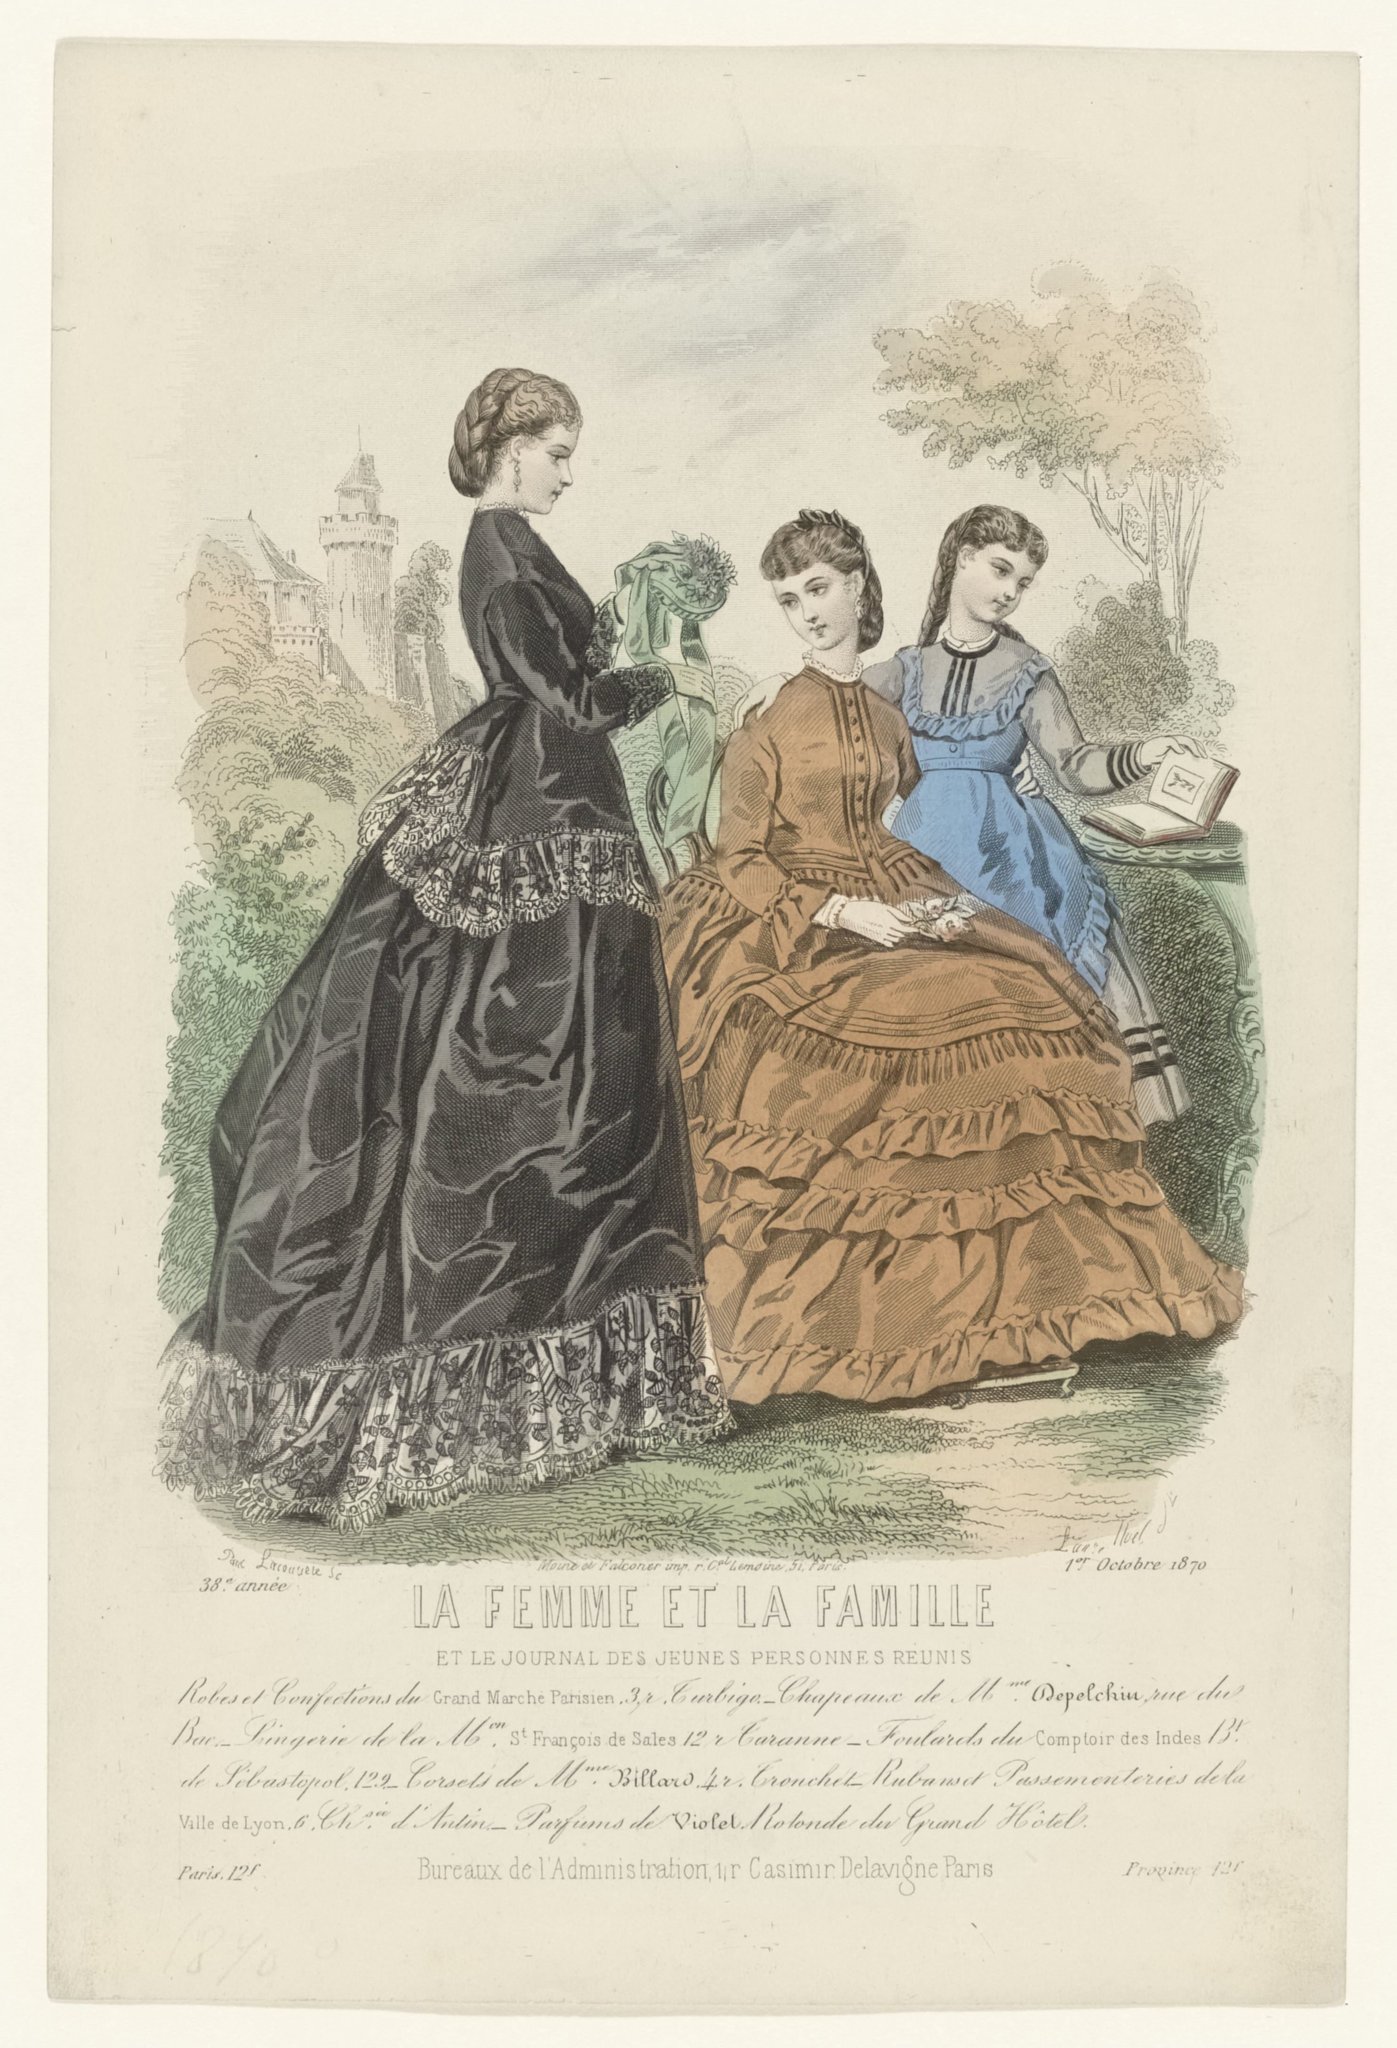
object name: fashion print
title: La femme et la famille et le journal des jeunes personnes reunis, 1 octobre 1870, 38e année: Robes et Confections (...)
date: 1870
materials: paper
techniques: engraving, hand coloring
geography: paris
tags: cut flowers; nosegay, bunch of flowers, fashion plates, head-gear: hat (+ women's clothes), dress, gown (+ women's clothes), book - mm - book open, dress, gown (+ girls' clothes)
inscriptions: caption: ‘Robes et Confections du Grand Marche Parisin, 3, r. Turbigo. _ Chapeaux de Mme Depelchin, rue du Bac_ Lingerie de la M.on St François de Sales 12 r Taranne _ Foulards du Comptoir des Indes B.t de Sébastopol, 129_ Corsets de Mme Billard 4. r. Cronchet_ Rubans et Passementeries de la Ville de Lyon. 6. Ch.sée_ Parfums de Violet. Rotonde du Grand Hôtel.’, address: ‘Paris. 12f / Bureaux de l'Administration, 1, r Casimir Delavigne Paris / province 12 f’, title: ‘LA FEMME ET LA FAMILLE / ET LE JOURNAL DES JEUNES PERSONNES REUNIS’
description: Twee vrouwen en een meisje in een tuin. Volgens het onderschrift: japonnen en confectie van Grand Marche Parisien. Hieronder enkele regels reclametekst voor verschillende producten. Prent uit het modetijdschrift La Femme et la Famille (1867-1905).